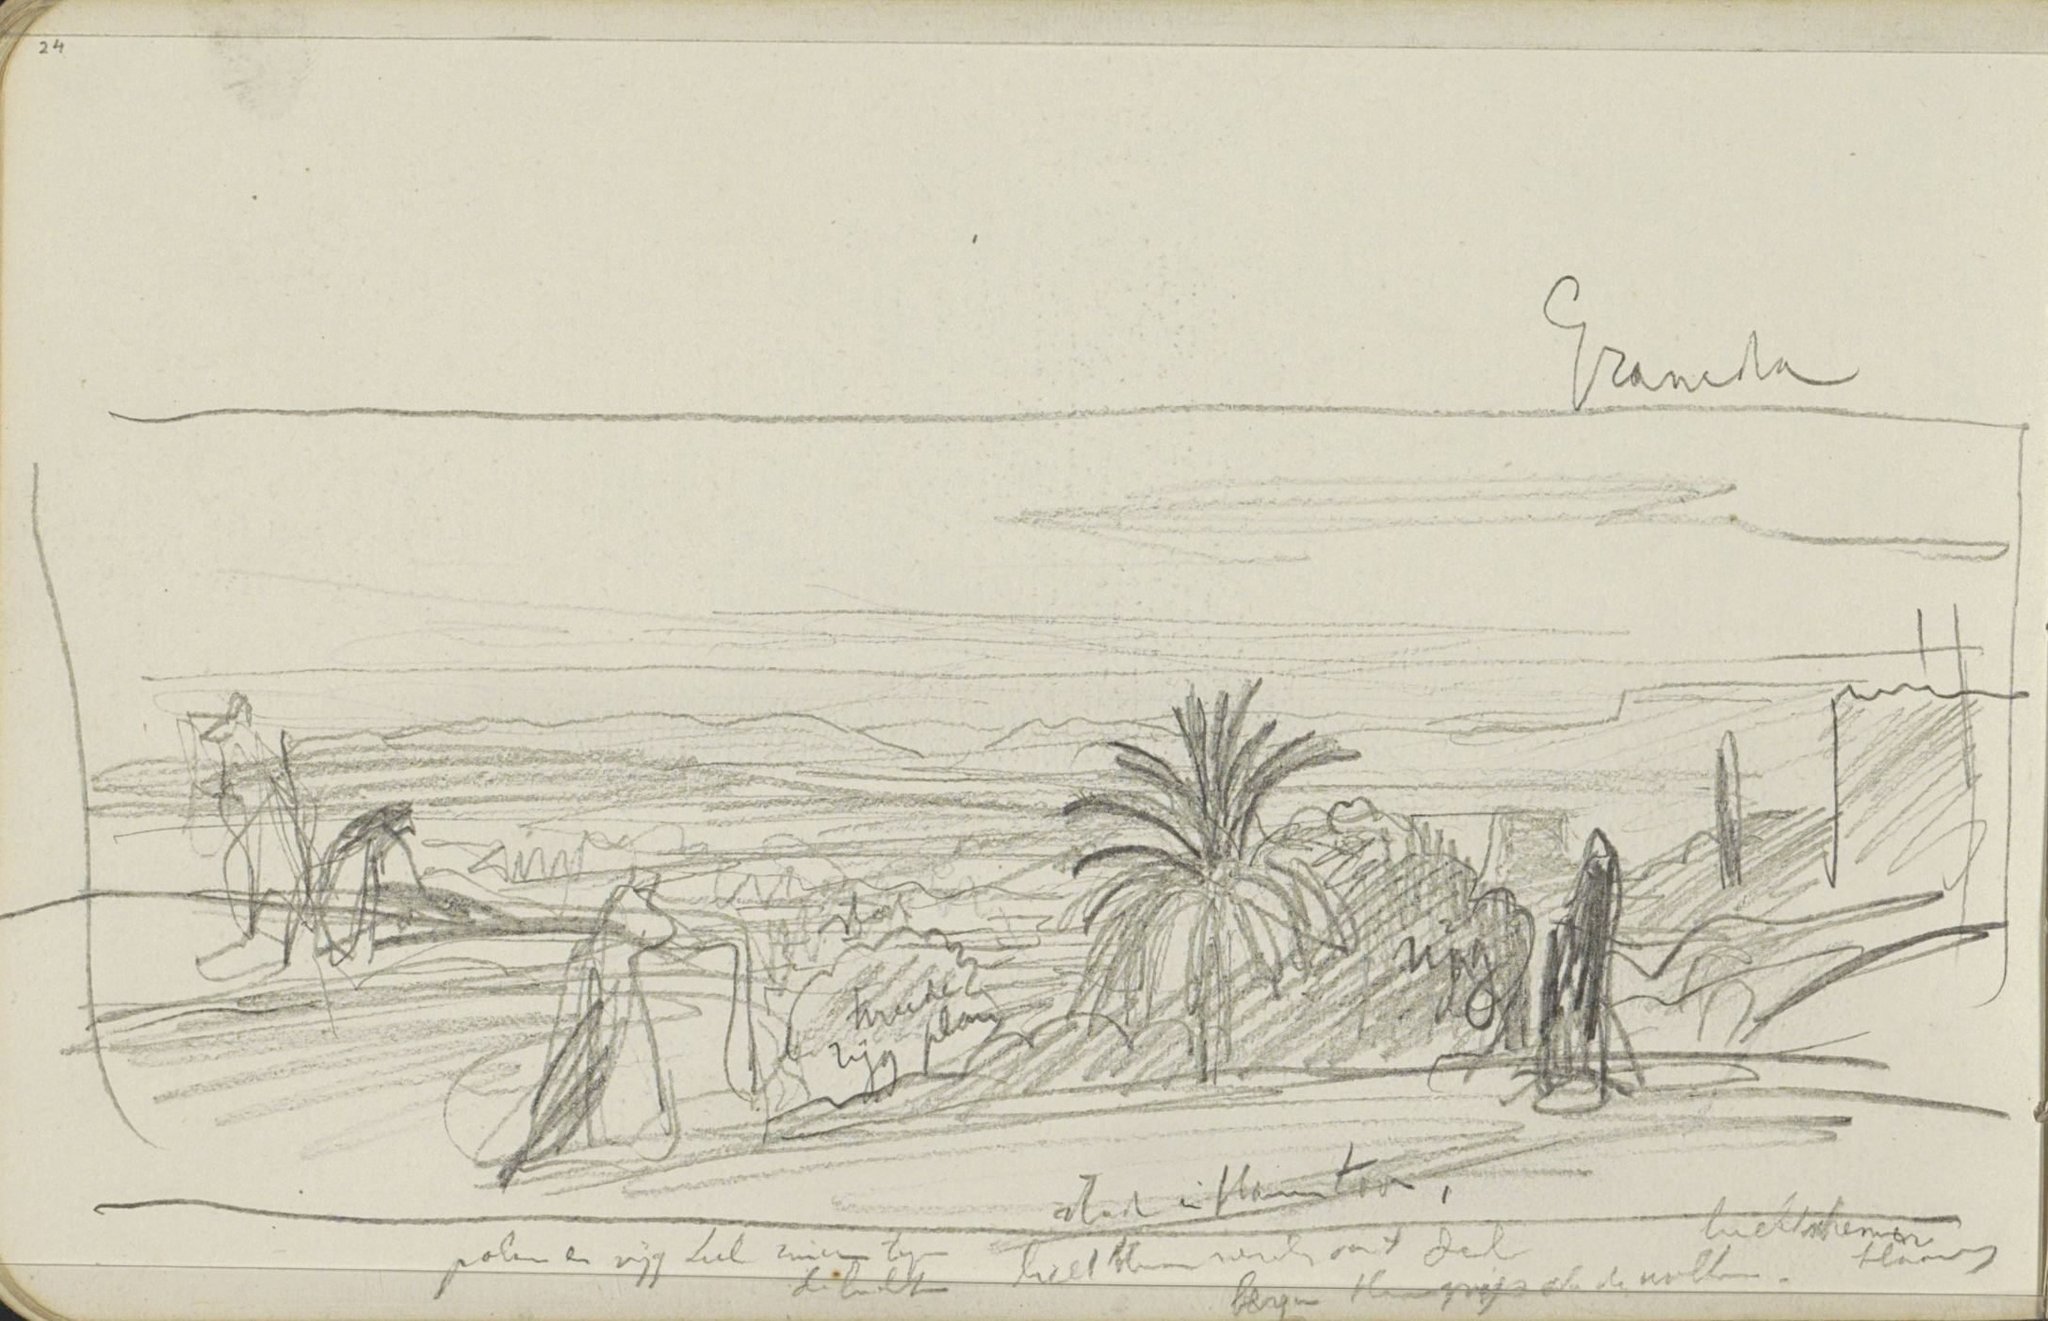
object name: sketchbook leaf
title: Landschap in Granada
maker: marius bauer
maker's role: draughtsman, print maker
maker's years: 1867-1932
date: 1902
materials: paper, pencil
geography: granada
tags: city-view, and landscape with man-made constructions, low hill country, trees: palm-tree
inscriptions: annotation: ‘Granada’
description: Op de voorgrond planten en een palmboom. Pagina 24 uit een schetsboek met 15 bladen.